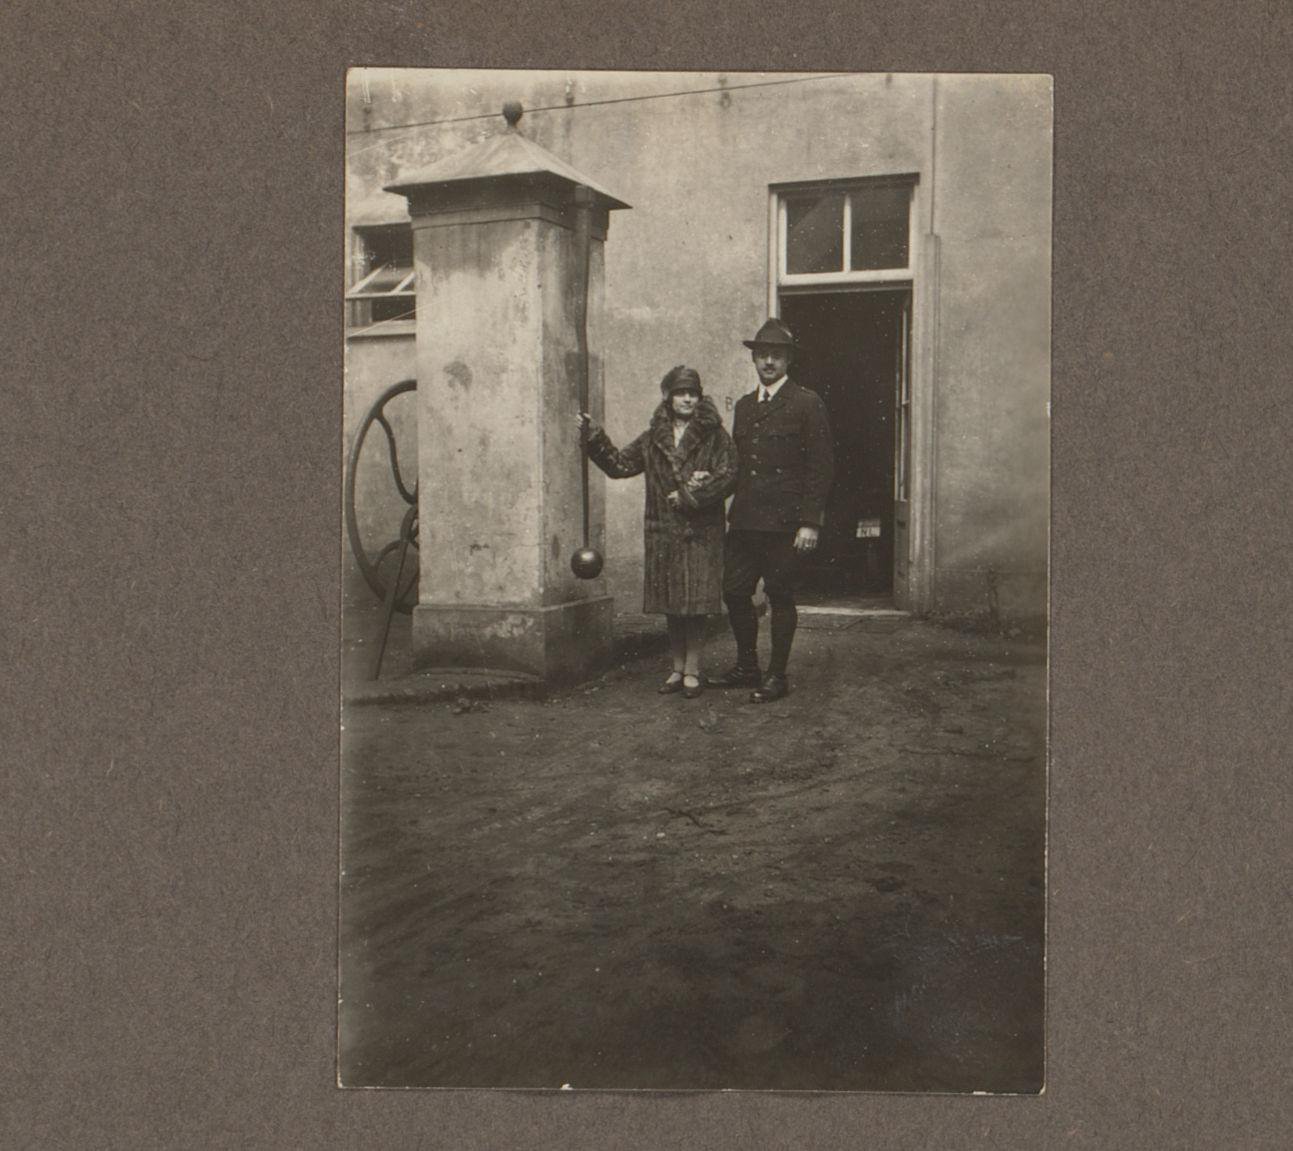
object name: album leaf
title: Henriëtte Wassink en Johannes van Zijll de Jong bij een waterpomp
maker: Anonymous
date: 1930-1935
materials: paper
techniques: gelatin silver print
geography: netherlands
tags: batavia, the hague, henriëtte wassink, mother and son(s) (family group), pump, netherlands